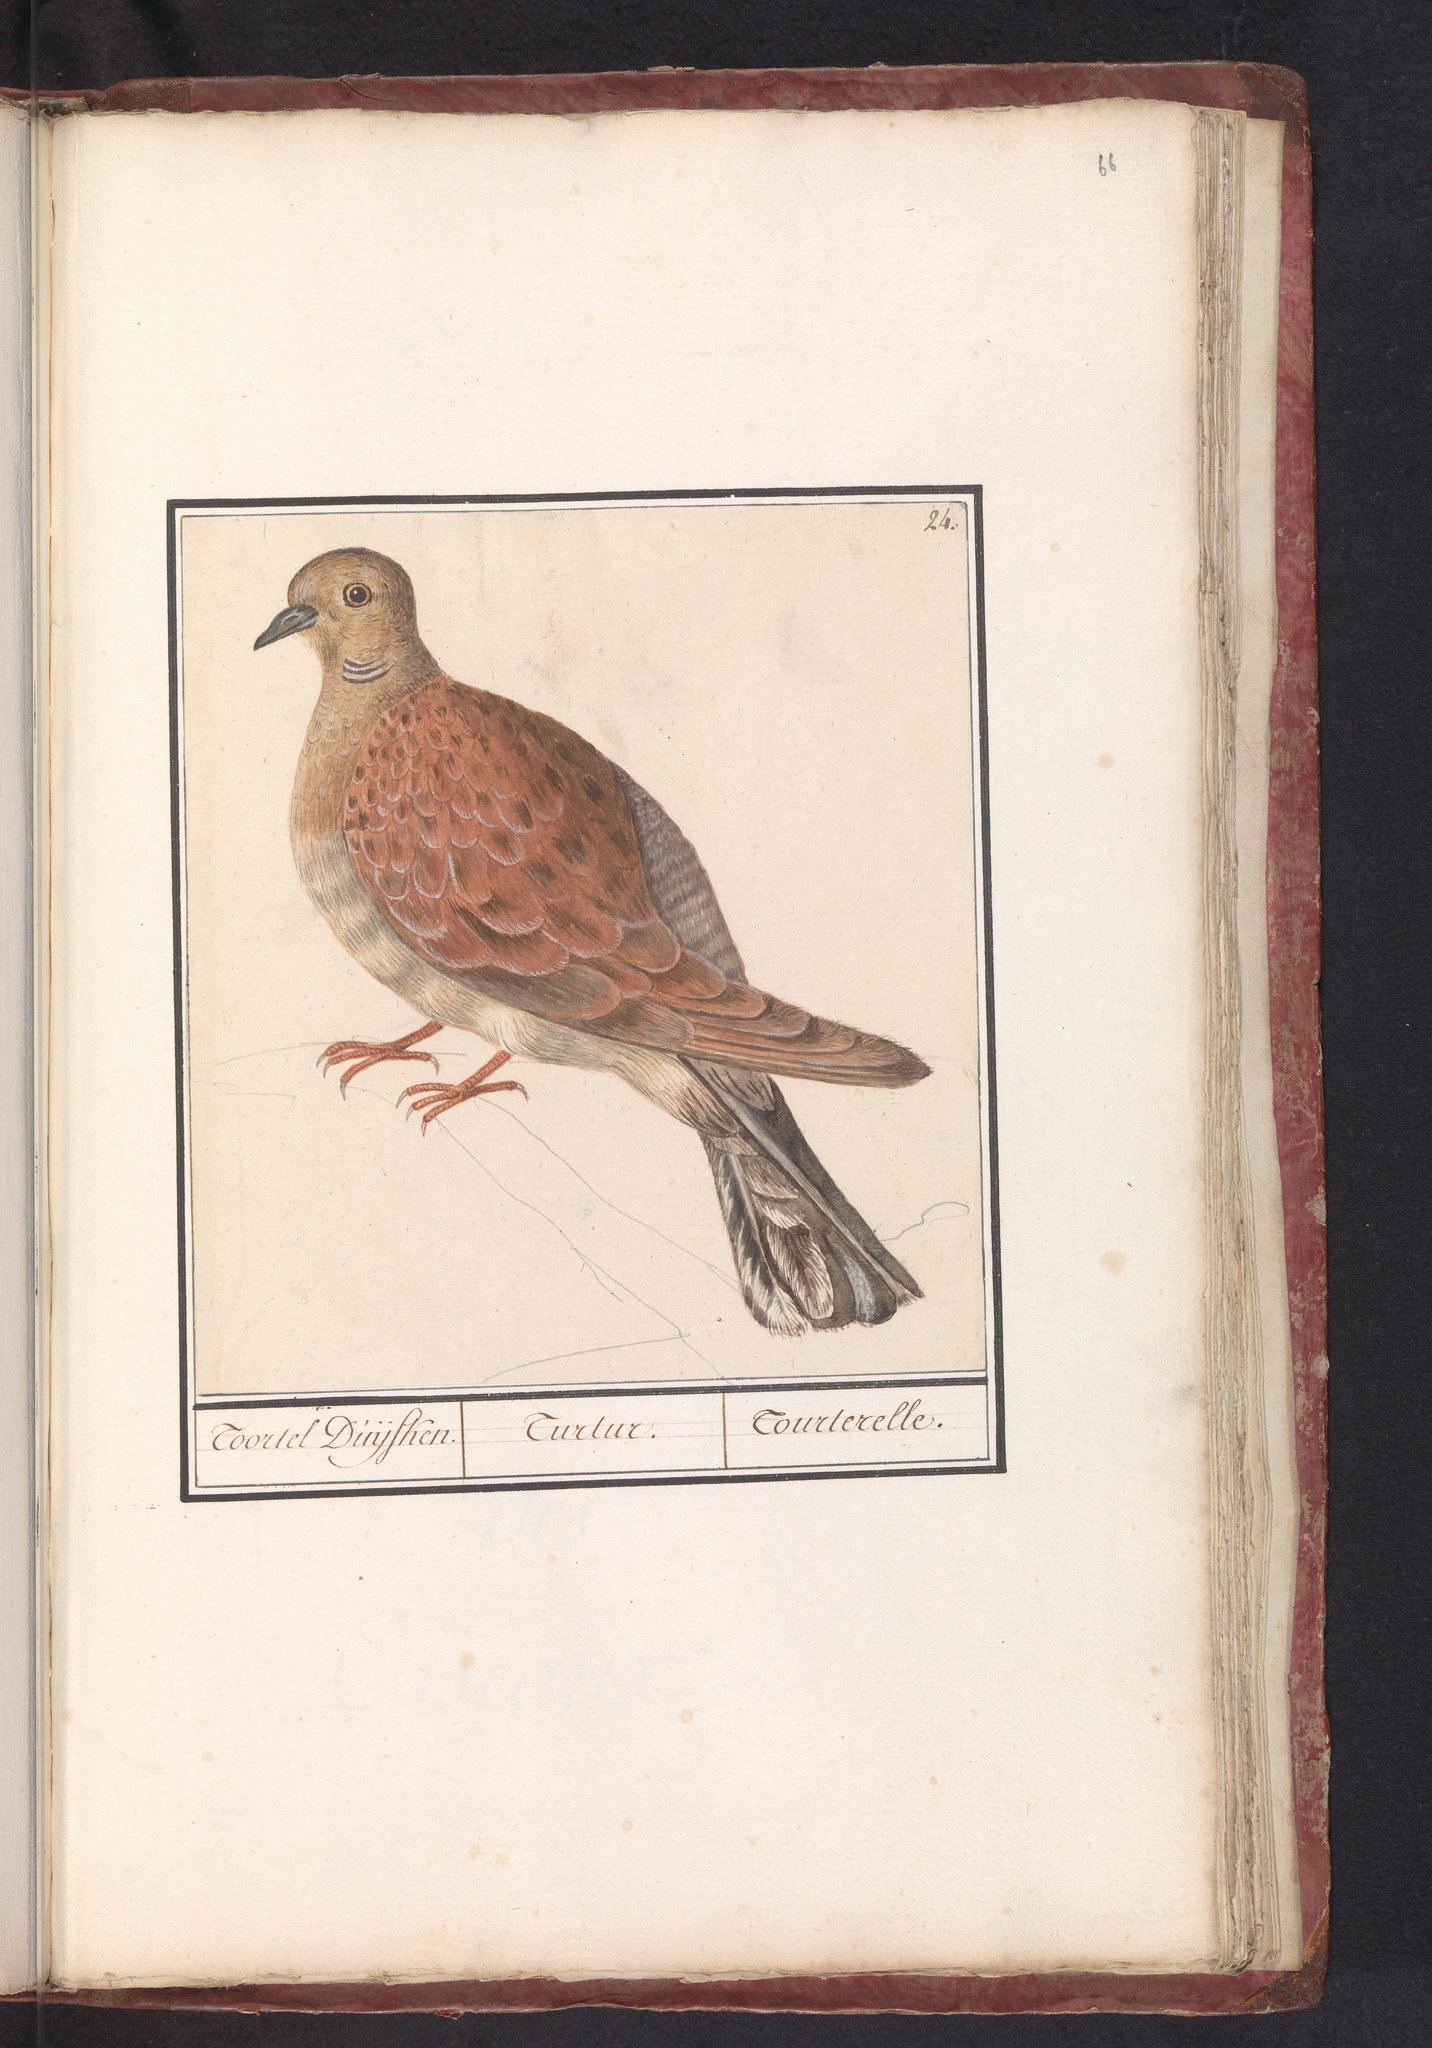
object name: drawing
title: Zomertortel (Streptopelia turtur)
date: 1596-1610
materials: paint, paper, pencil, watercolor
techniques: brush, pen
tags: other birds: dove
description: Zomertortel, vroeger bekend als tortelduif. Genummerd rechtsboven: 24. Onderdeel van het eerste album met tekeningen van vogels. Derde van twaalf albums met tekeningen van dieren, vogels en planten bekend rond 1600, gemaakt in opdracht van keizer Rudolf II. Met toelichting in Nederlands, Latijn en Frans.